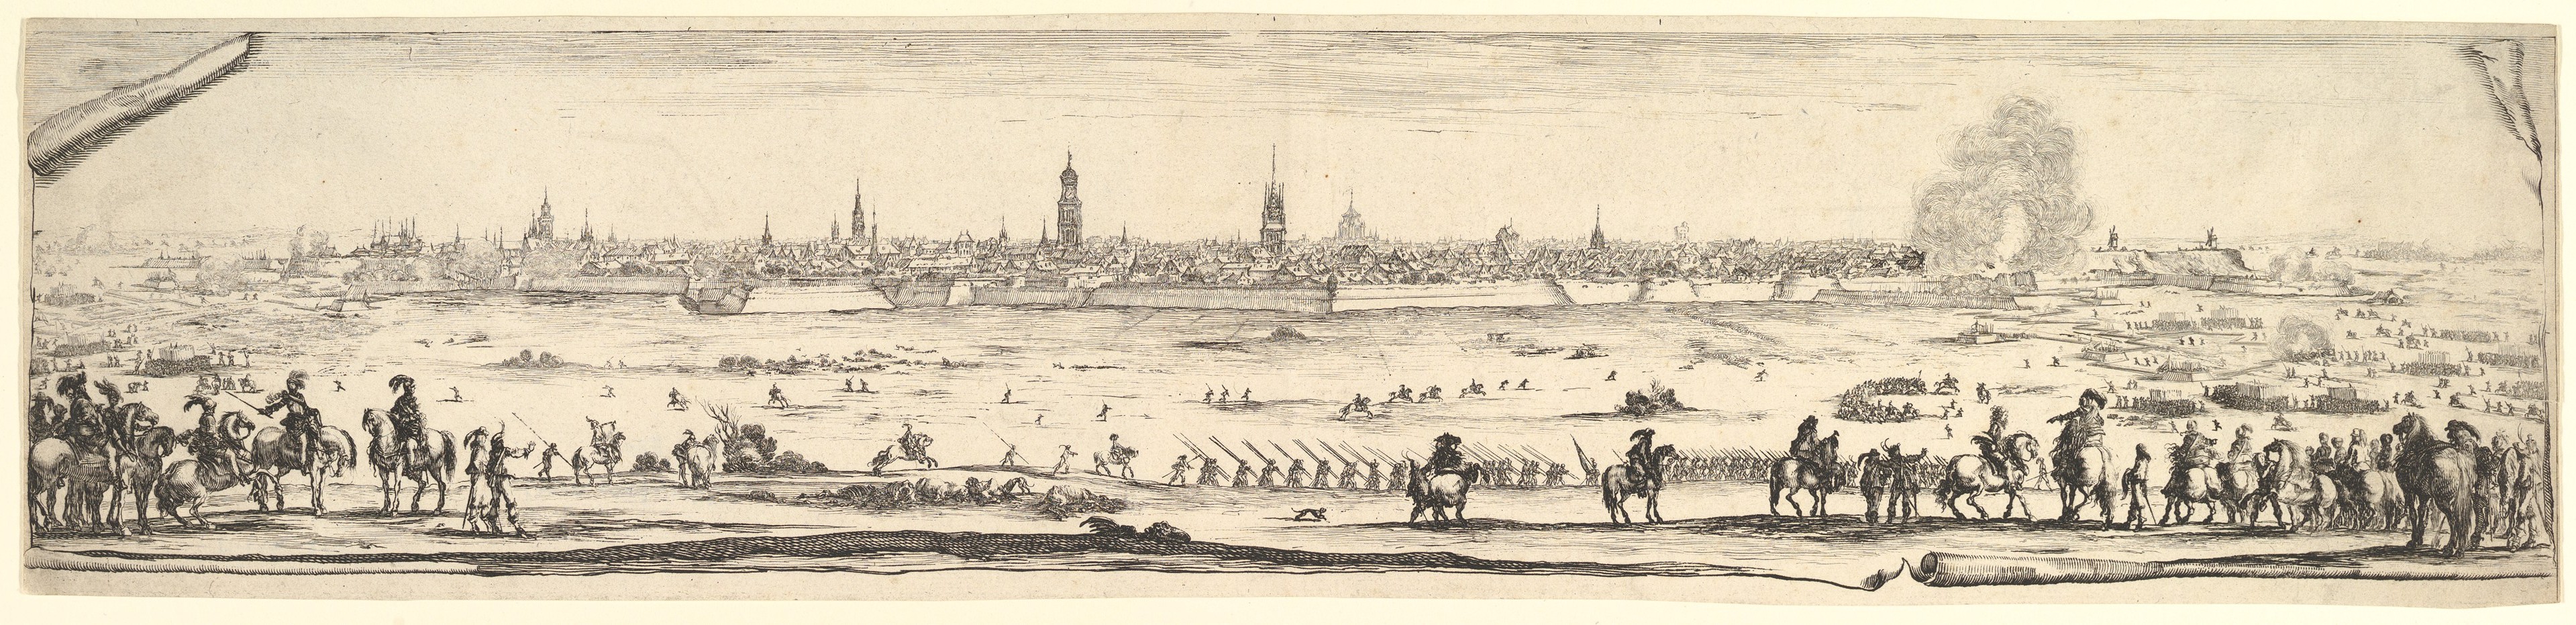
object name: print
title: Plan and view of the city of Arras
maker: stefano della bella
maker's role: artist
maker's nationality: italian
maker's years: 1610-1664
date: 1641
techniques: etching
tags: cities,soldiers,men,horses